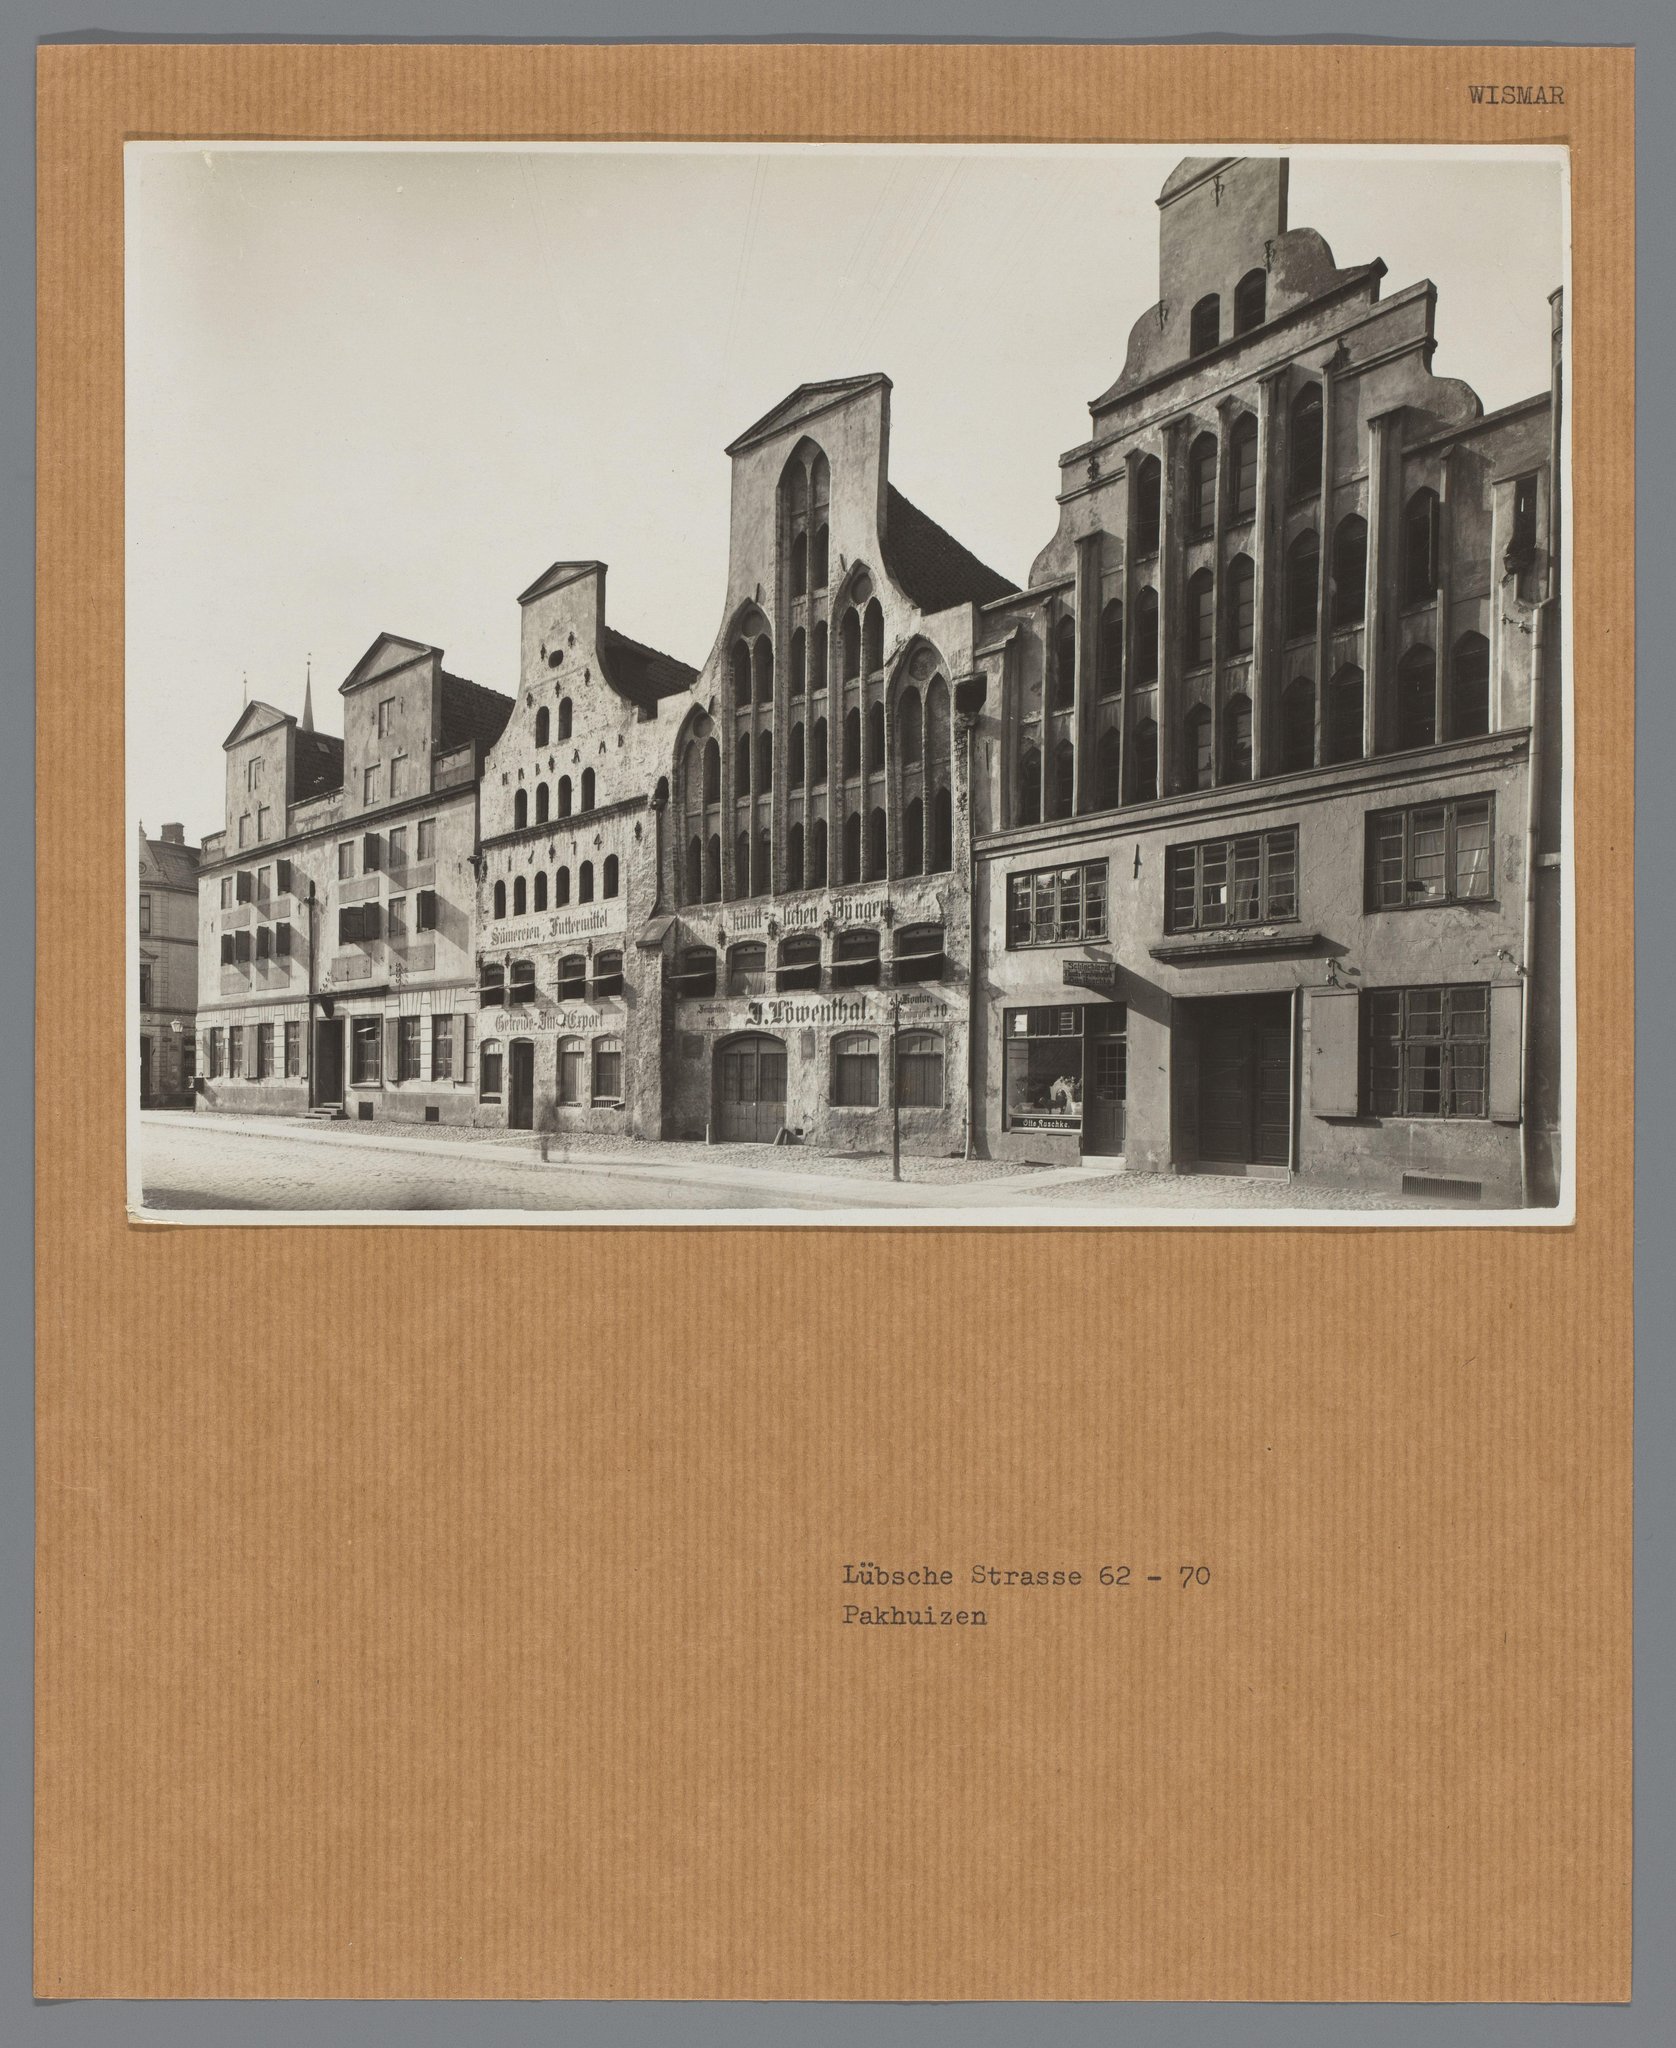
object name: photograph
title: Wismar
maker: Anonymous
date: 1900-1950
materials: paper, photographic support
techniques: gelatin silver print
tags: germany